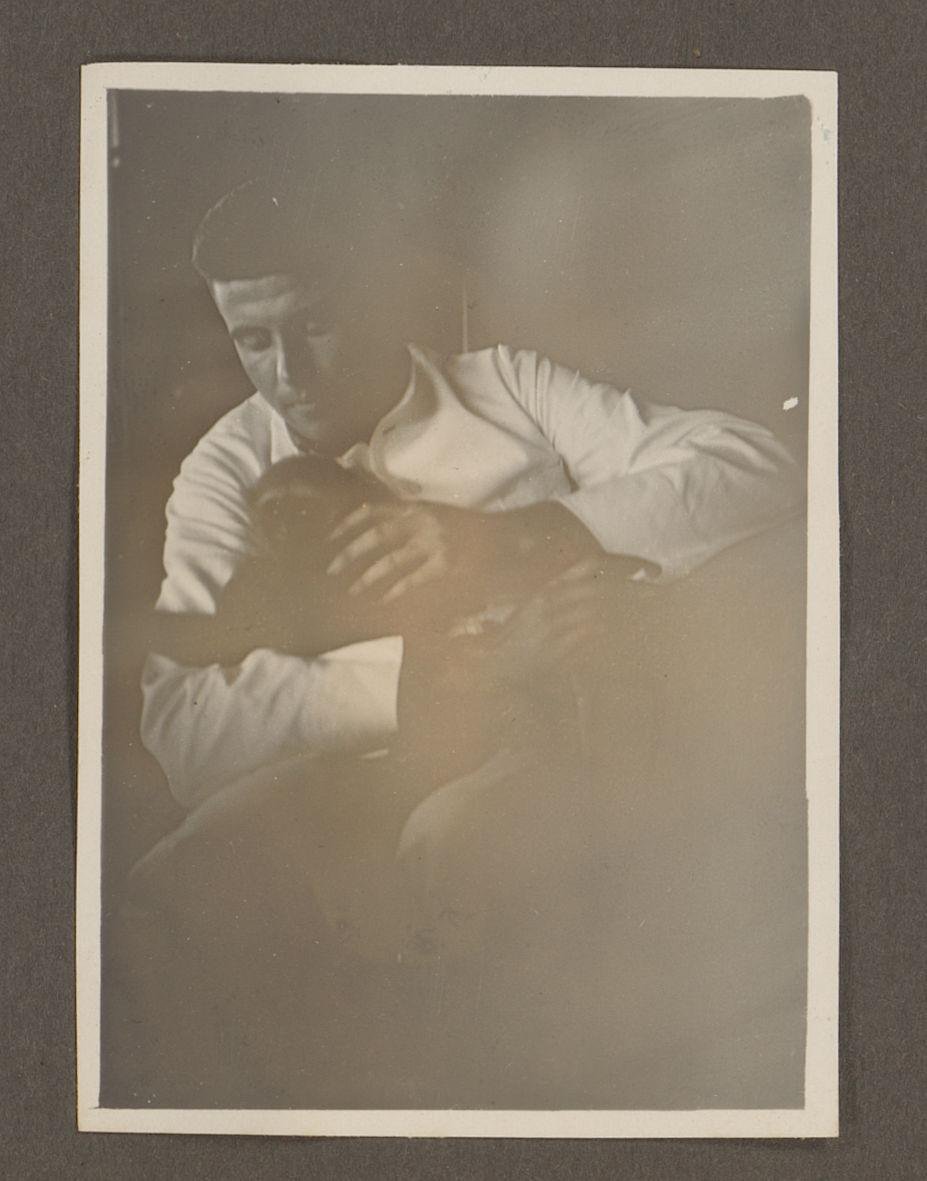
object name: photograph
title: Man met een meerkat op schoot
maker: Anonymous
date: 1920-1930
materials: photographic support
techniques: gelatin silver print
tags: monkeys, apes, taming, domestication of animals; tamed or domesticated animal, friendship between man and animal; caressing, petting, dutch east indies, the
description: Onderdeel van familiealbum Nederlands-Indië.